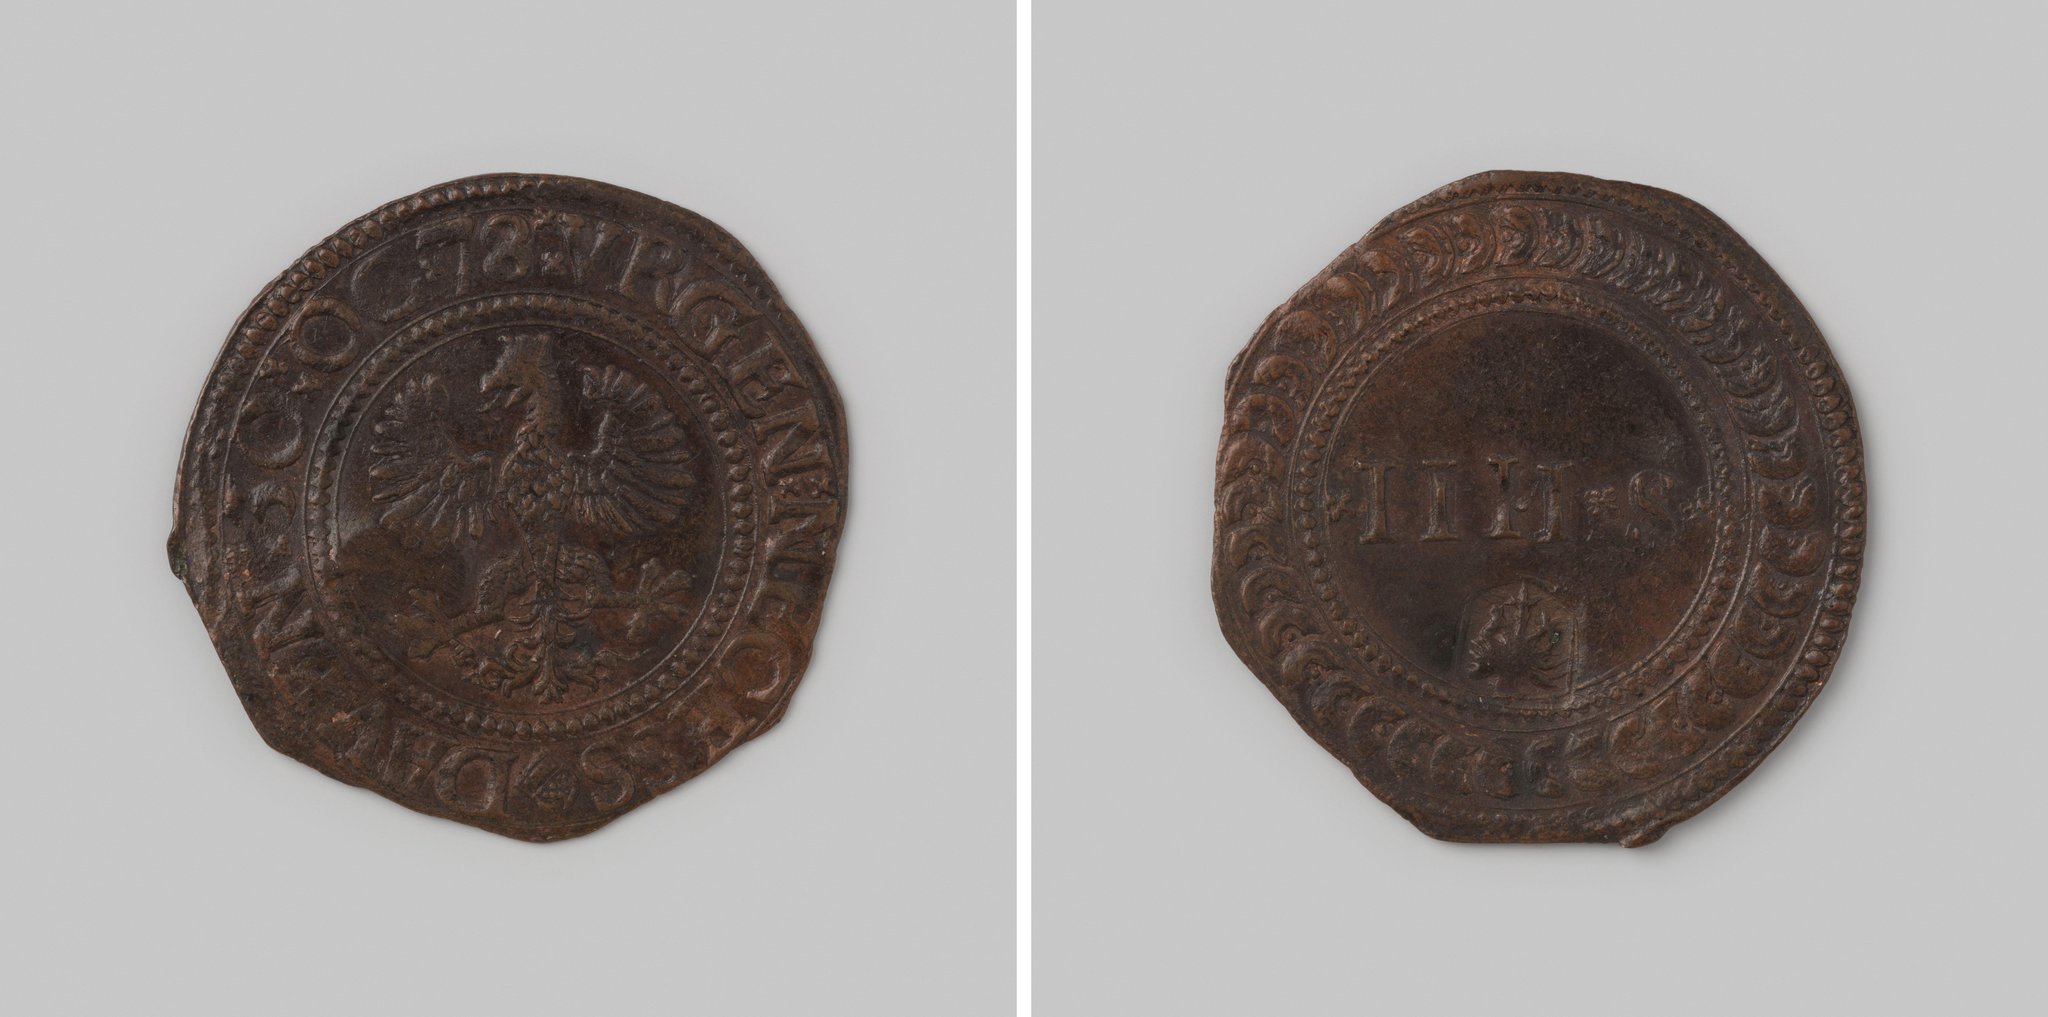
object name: coin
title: Stad Deventer, noodmunt van 4 stuiver, 1578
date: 1578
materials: copper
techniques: striking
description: Koperen noodmunt. Voorzijde: binnen parelcirkel gekroonde enkelkoppige adelaar naar links. Omschrift: Vrgen. Necess [stadswapenschildje] Daven. 30 Oc 78. Keerzijde: binnen parelcirkel op een regel waarde-aanduiding: IIII S. Buiten parelcirkel krans. Met klop stadswapenschildje?.